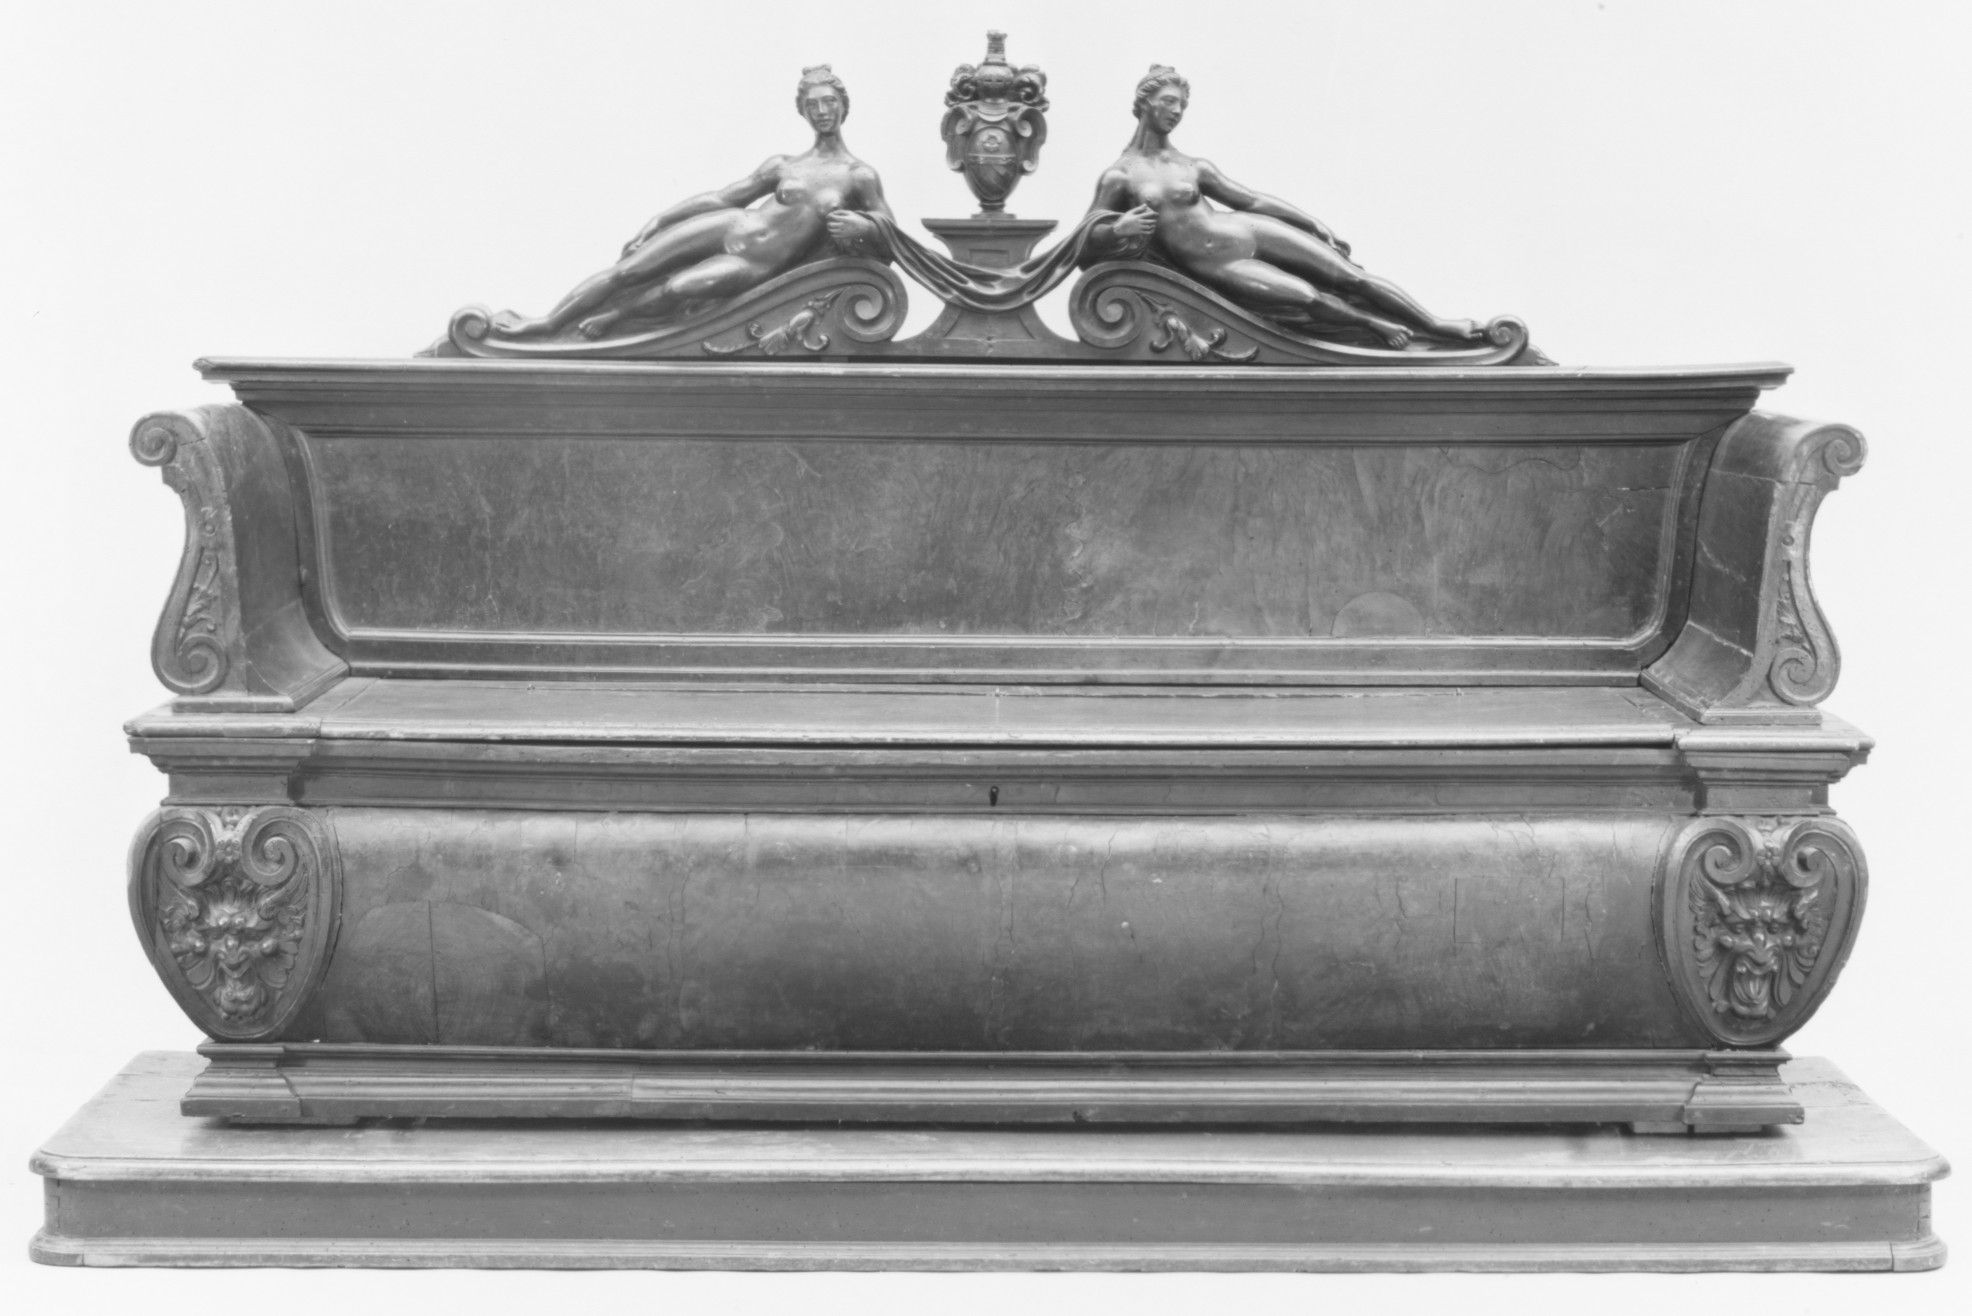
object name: cassapanca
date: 1551-1575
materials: wood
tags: female nudes